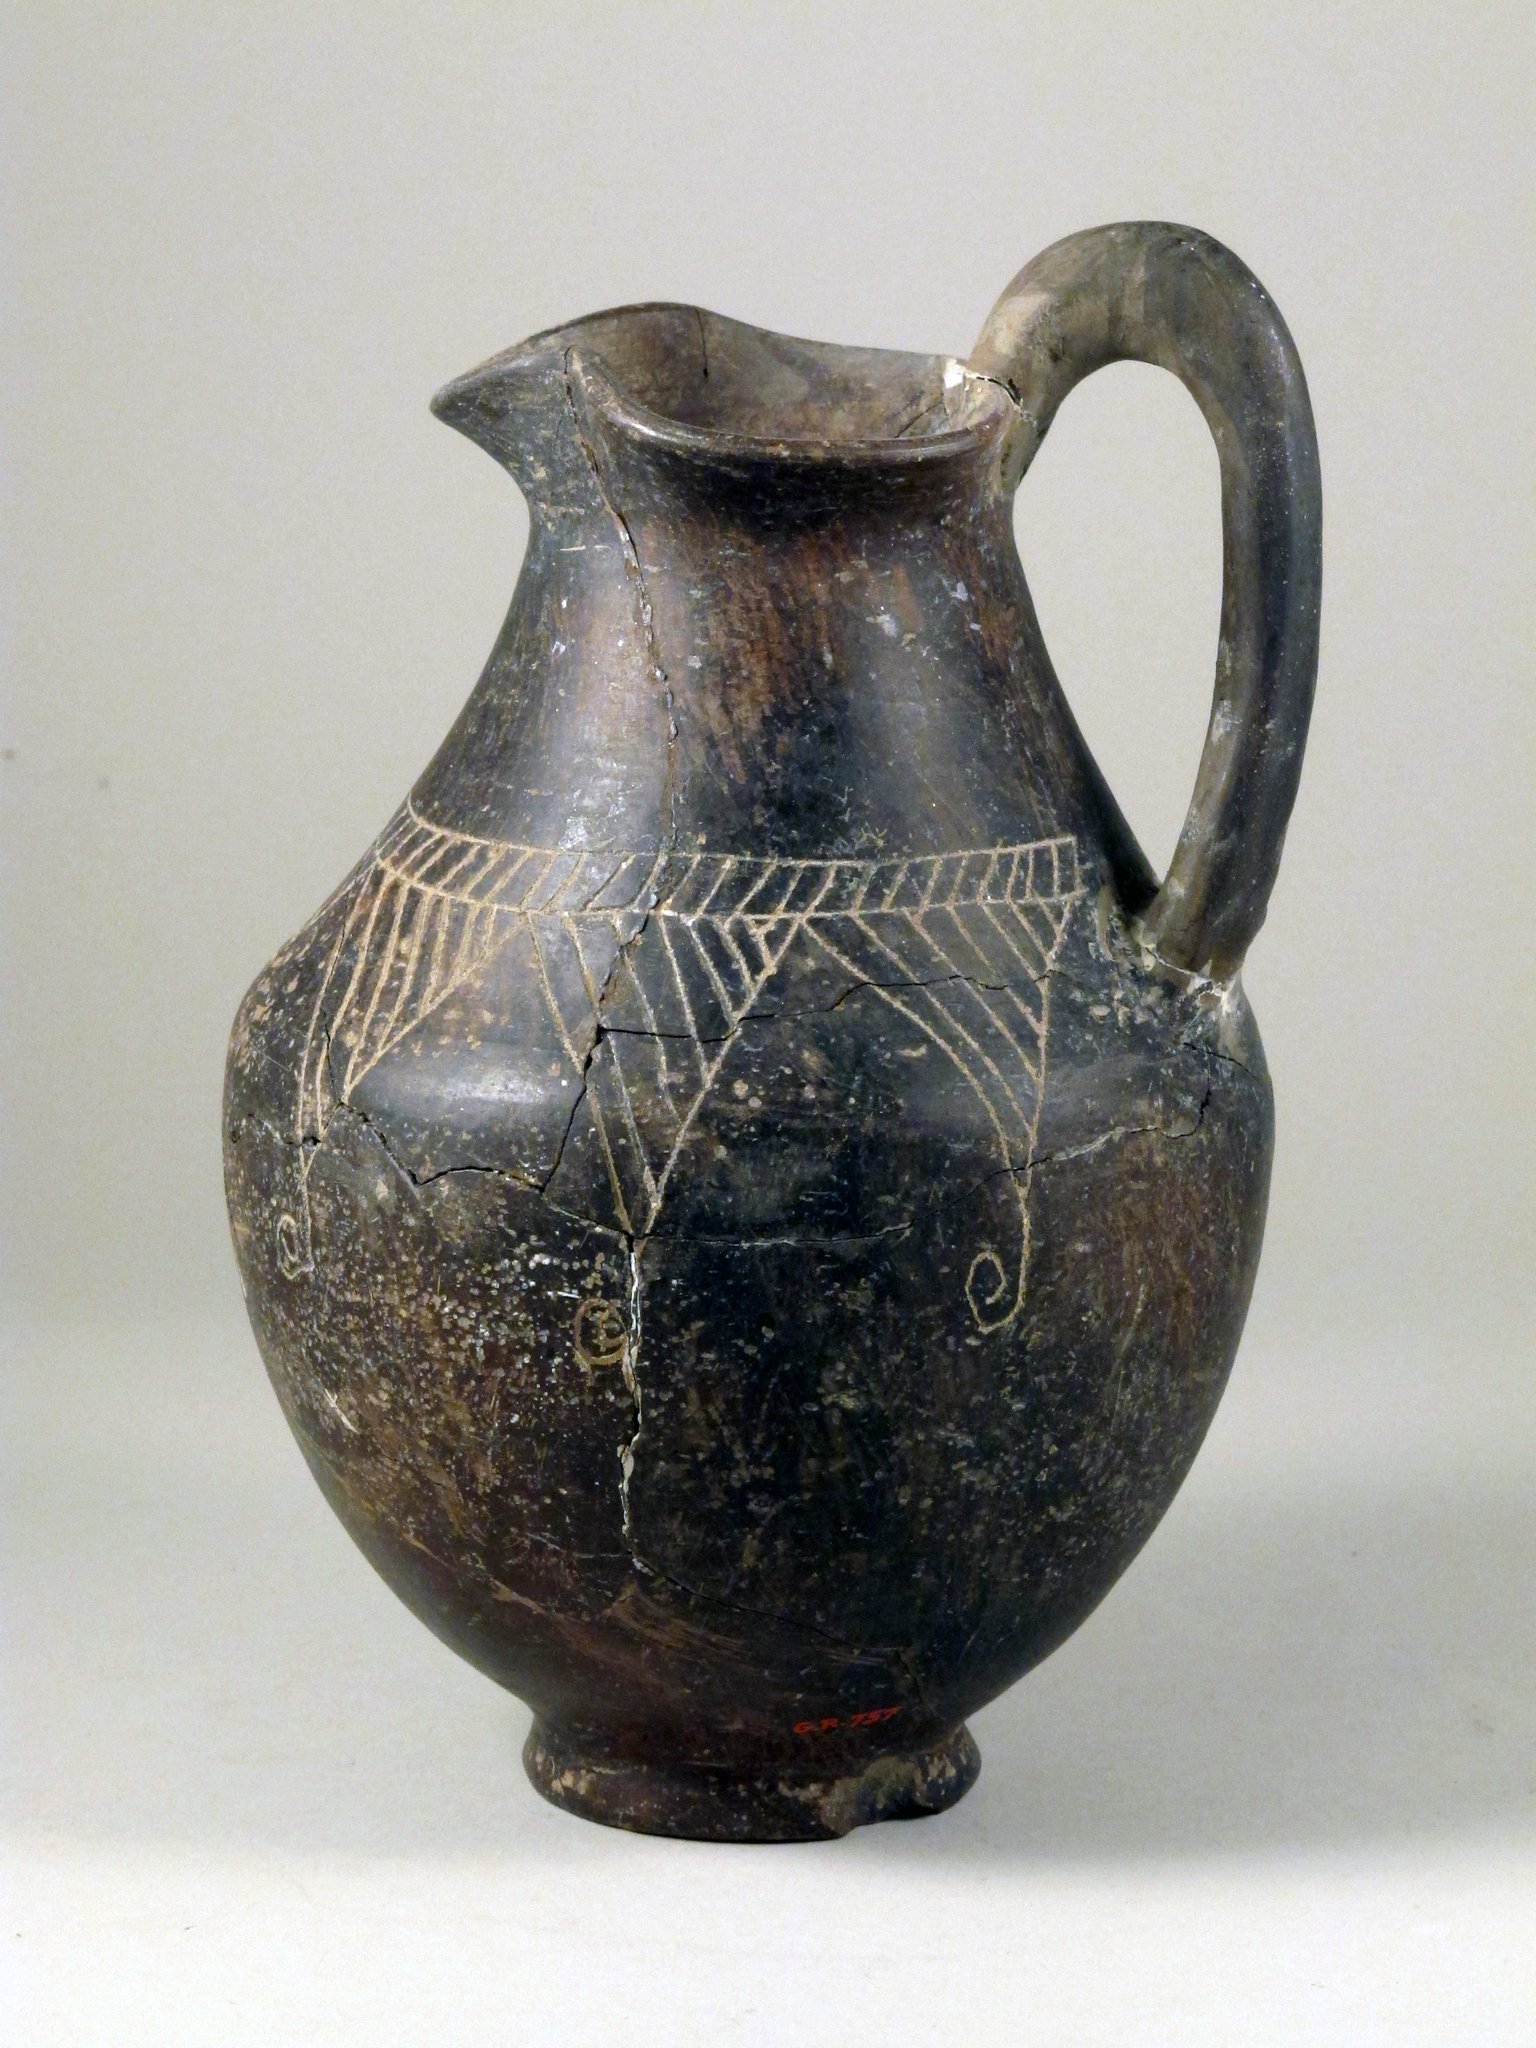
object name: jug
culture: italic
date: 900-100 BCE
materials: terracotta